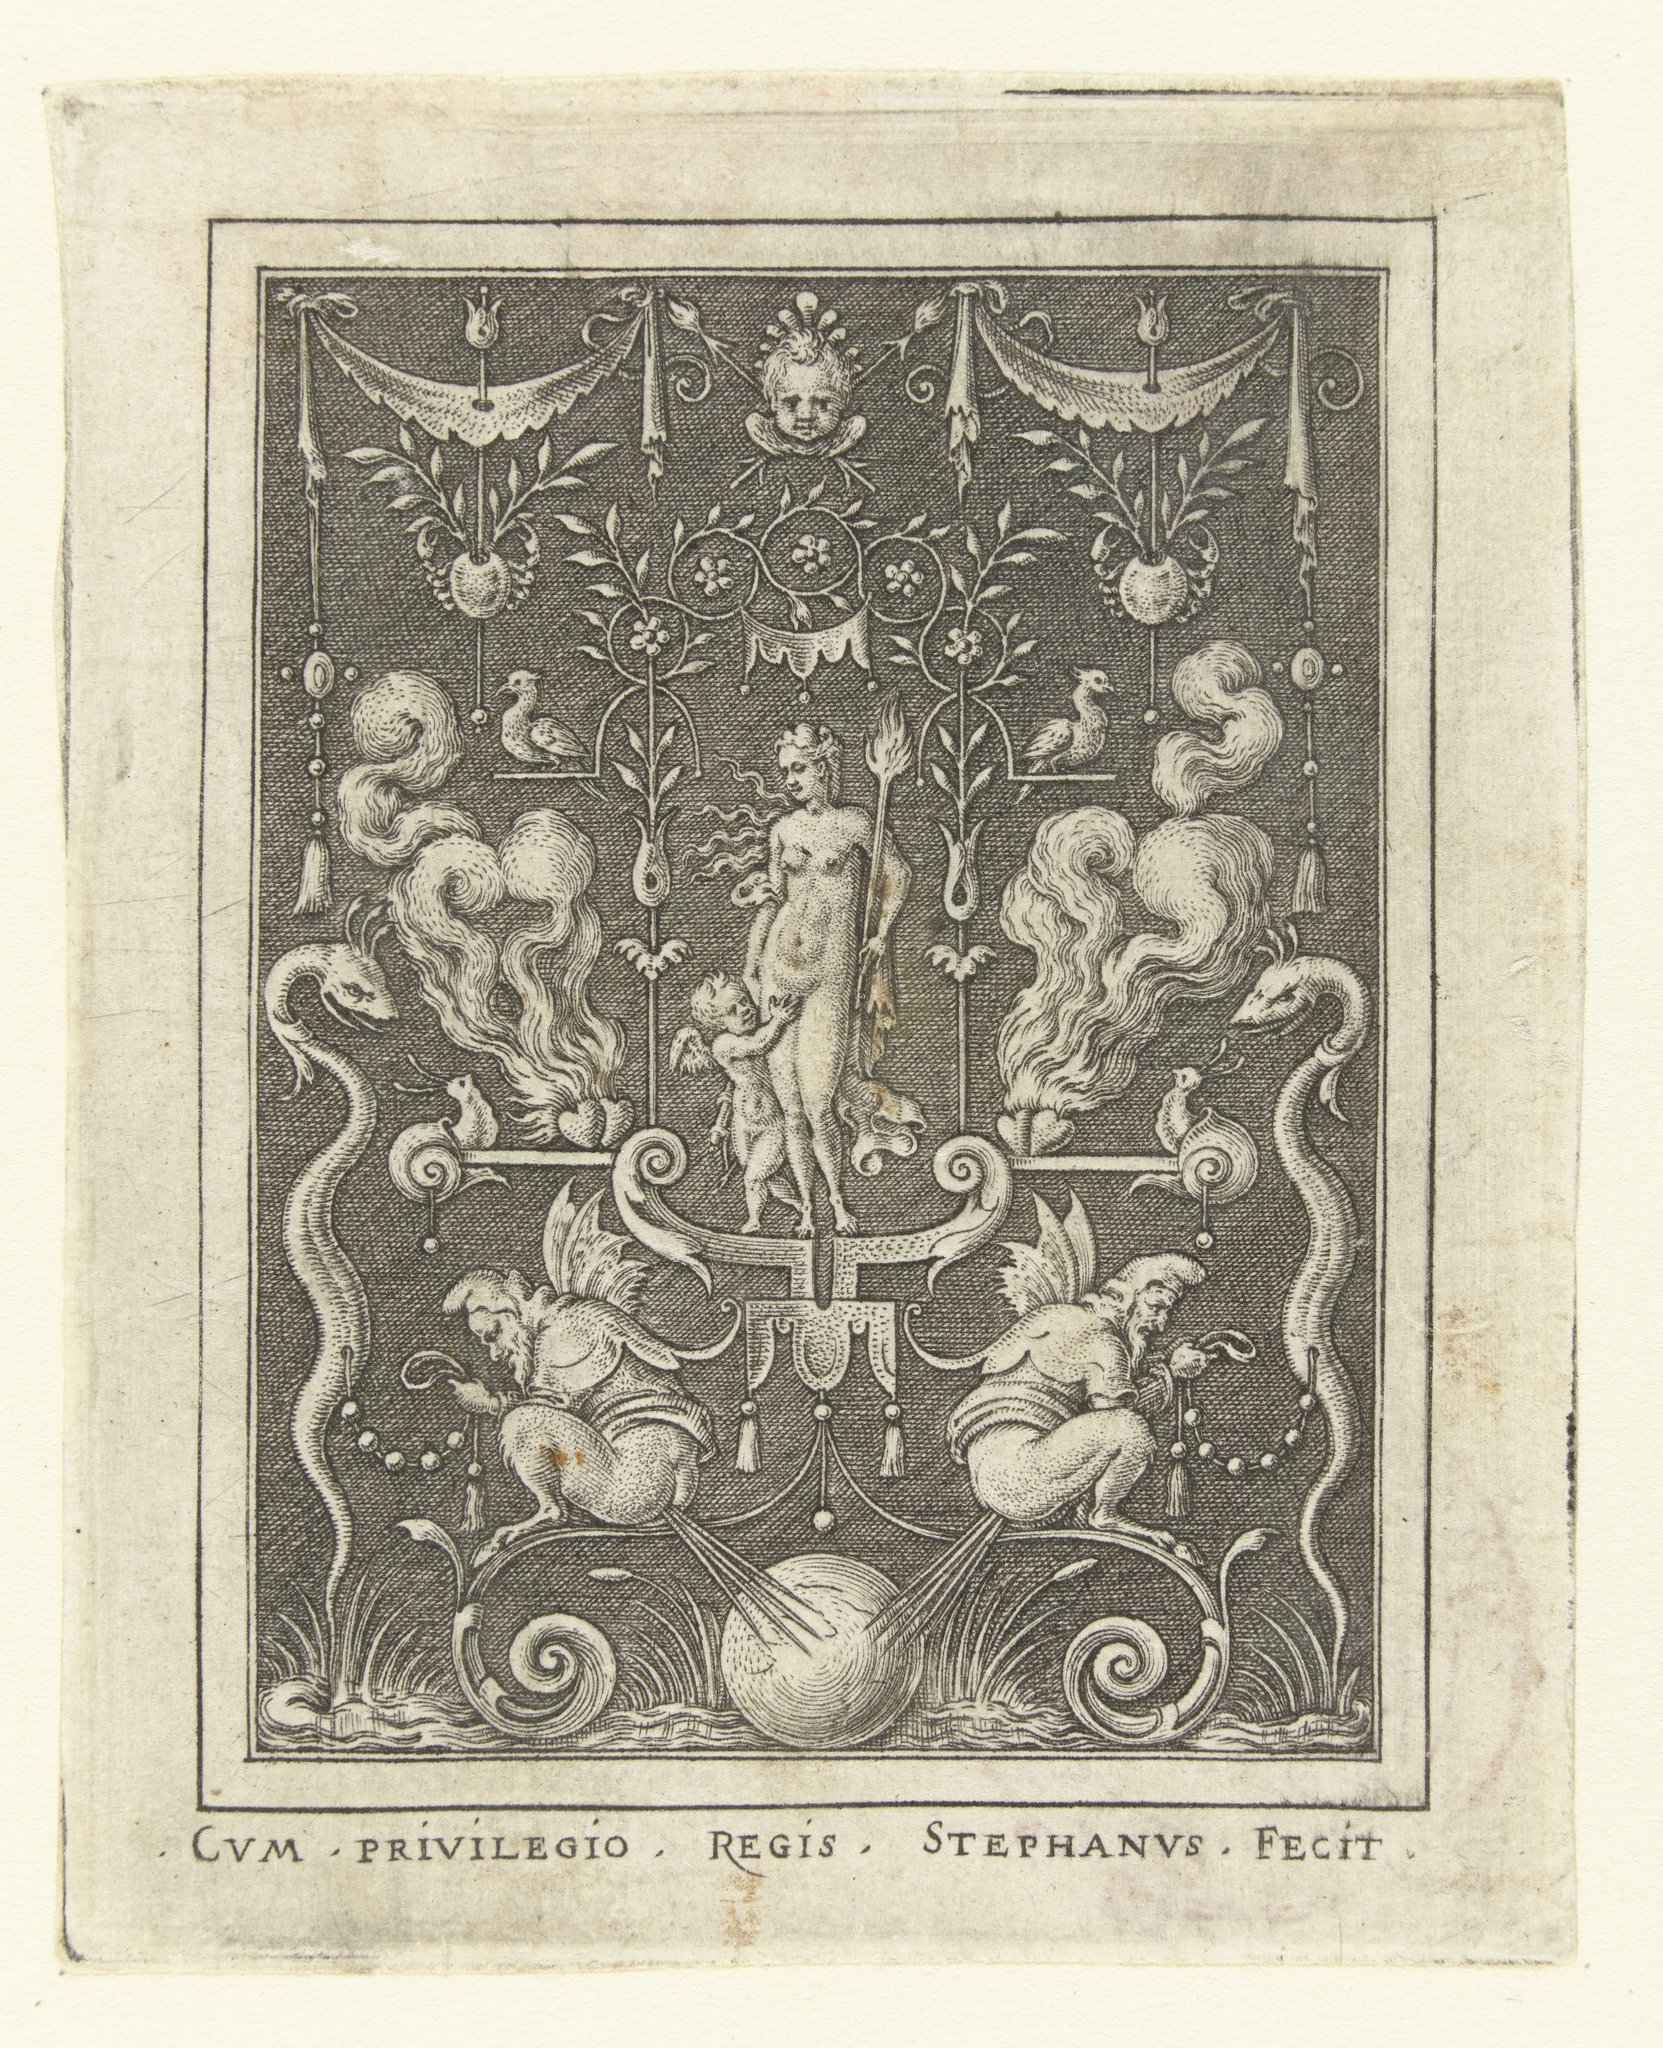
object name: print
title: Vlakdecoraties met godenfiguren in een omlijsting van grotesken (latere versie)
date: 1528-1583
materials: paper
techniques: engraving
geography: france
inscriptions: collector's mark: Lugt 240